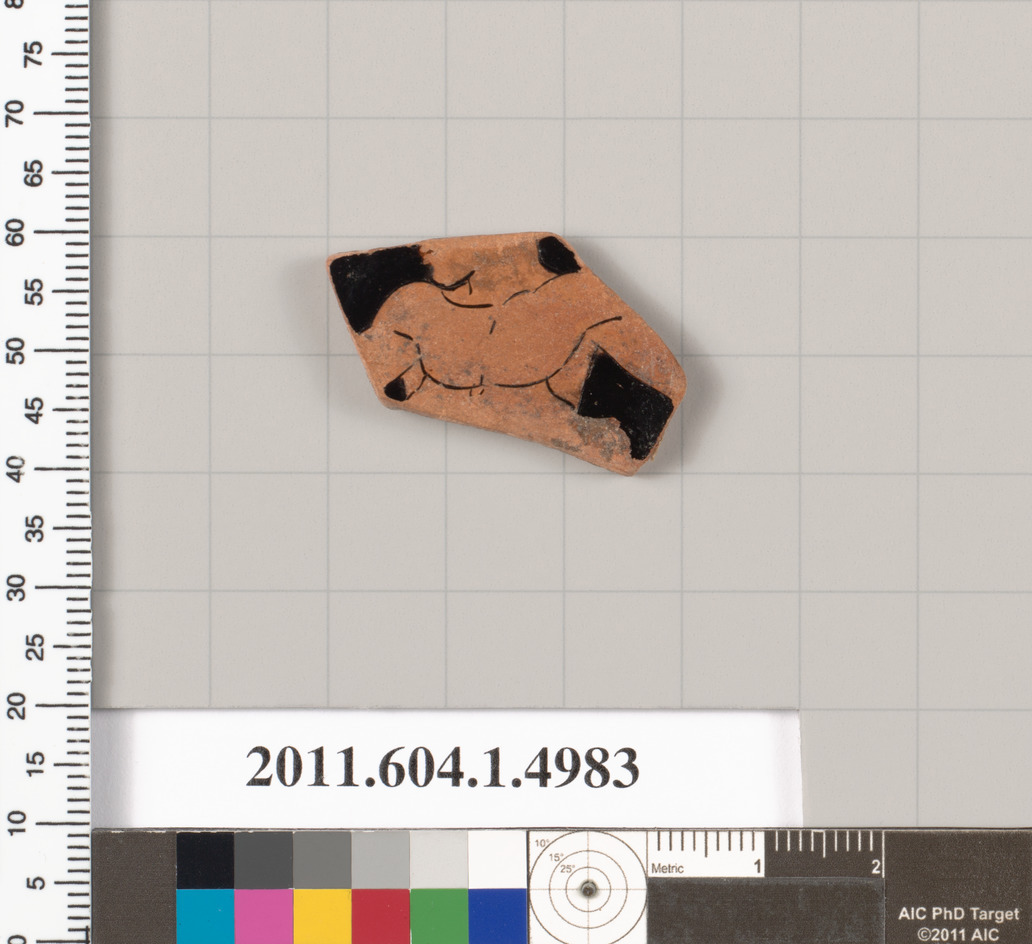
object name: kylix fragment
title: Terracotta fragment of a kylix (drinking cup)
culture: greek, attic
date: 490-480 BCE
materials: terracotta